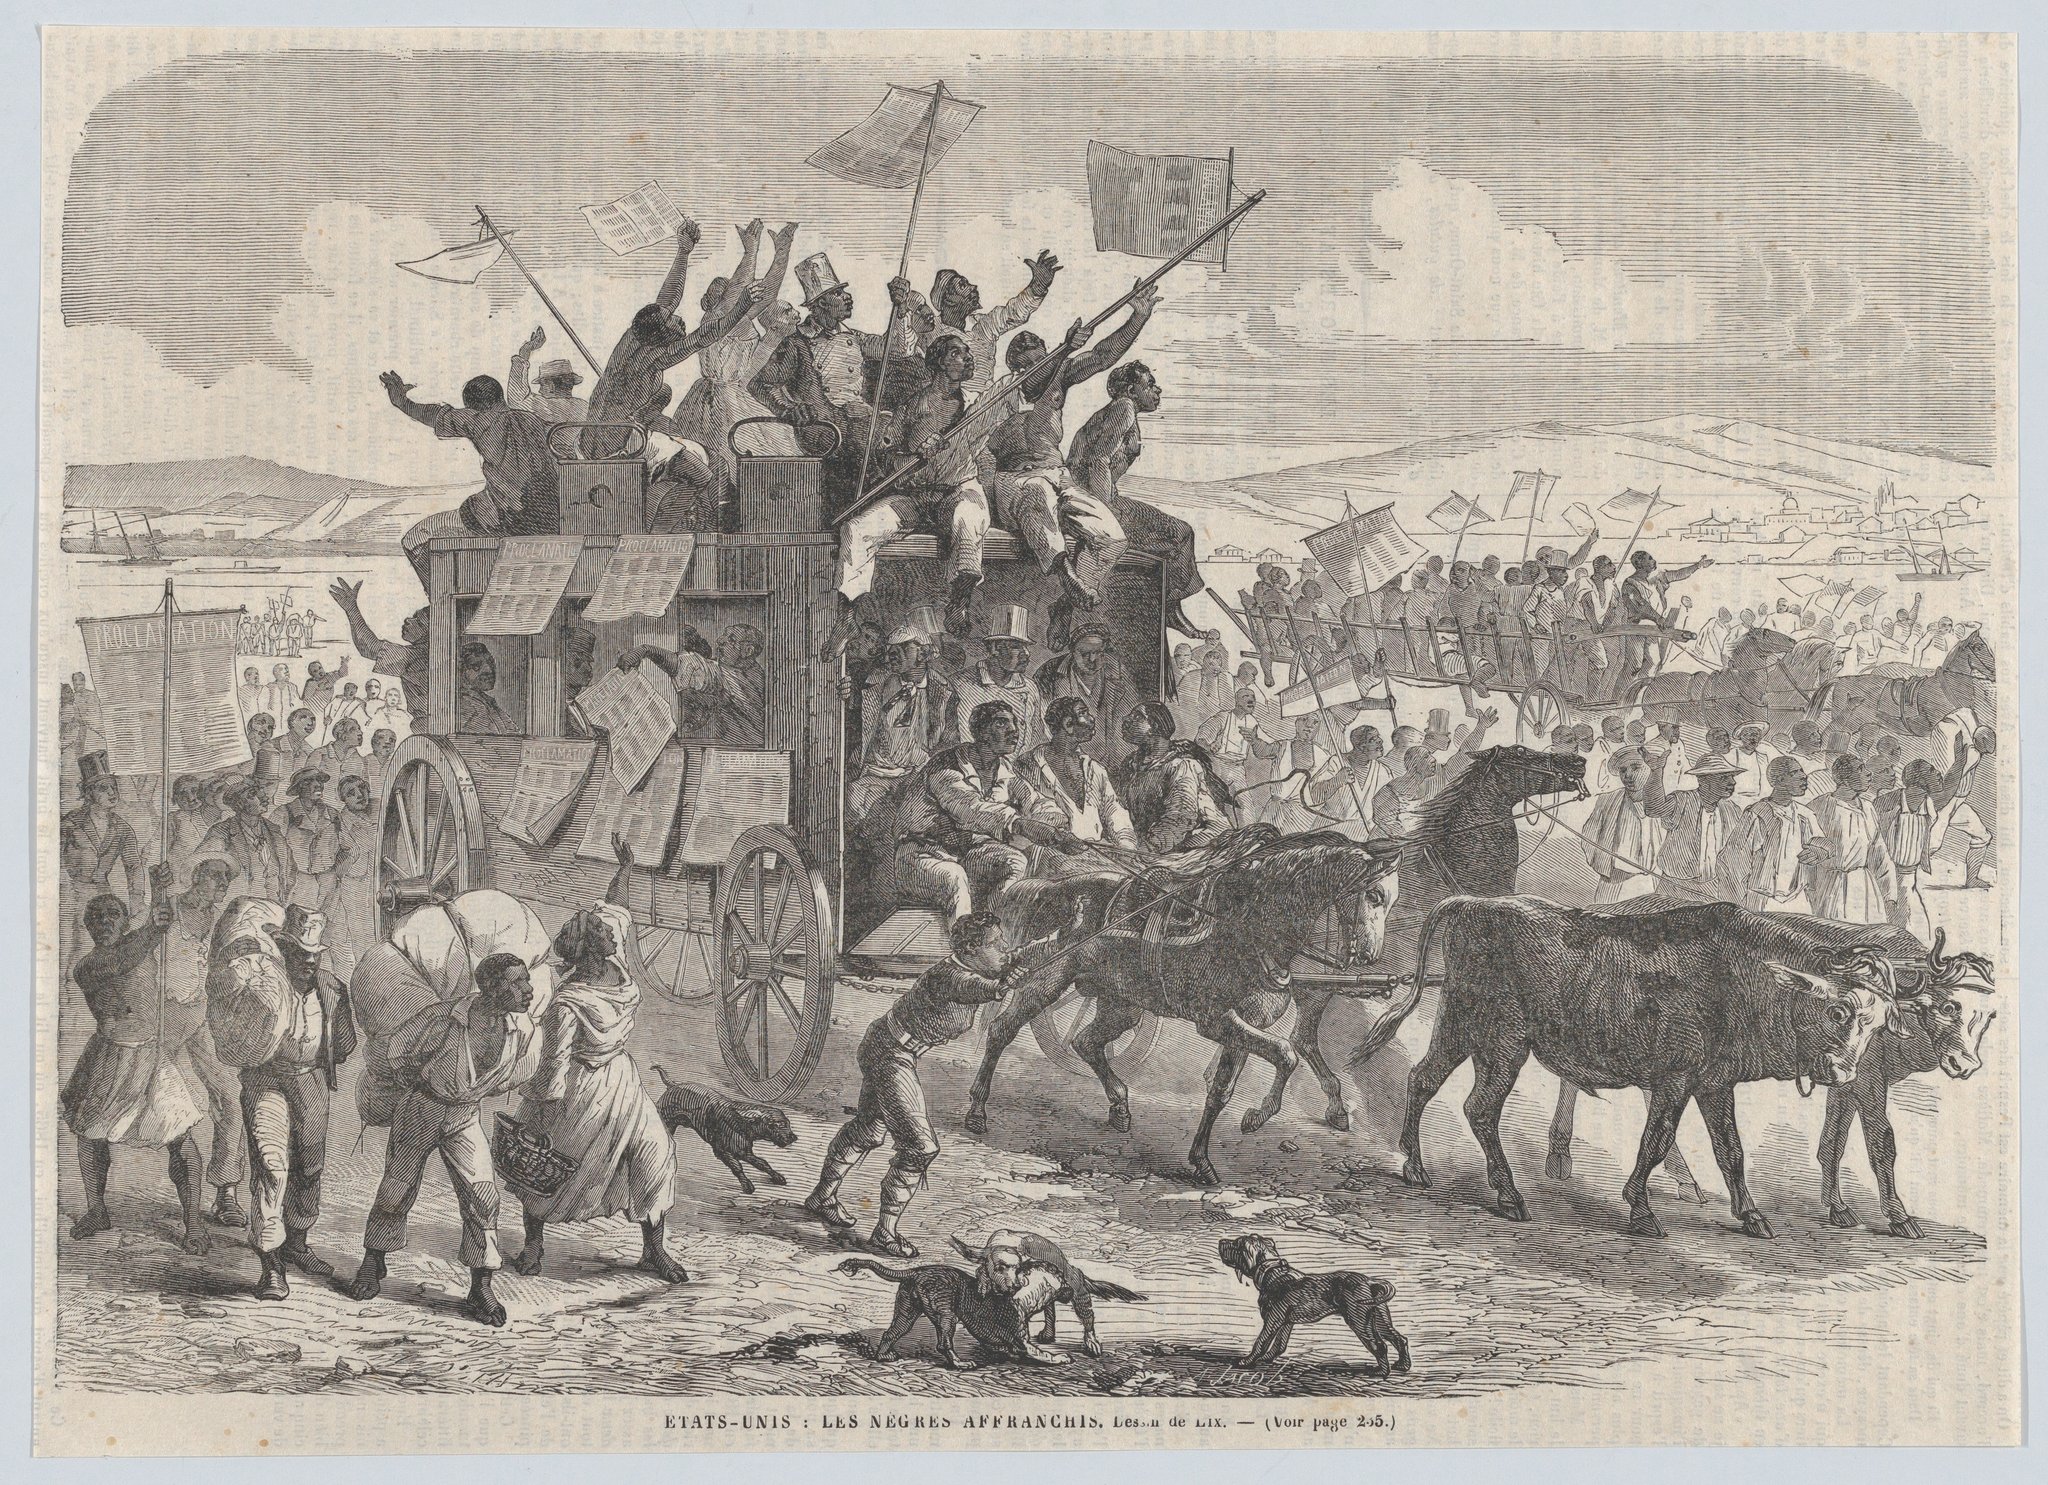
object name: print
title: Emancipated Blacks in the United States, from "Le Journal Illustré"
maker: amand jacob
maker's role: engraver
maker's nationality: french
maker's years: 1834-1895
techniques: engraving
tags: men,women,dogs,horses,carriages,ox,slaves